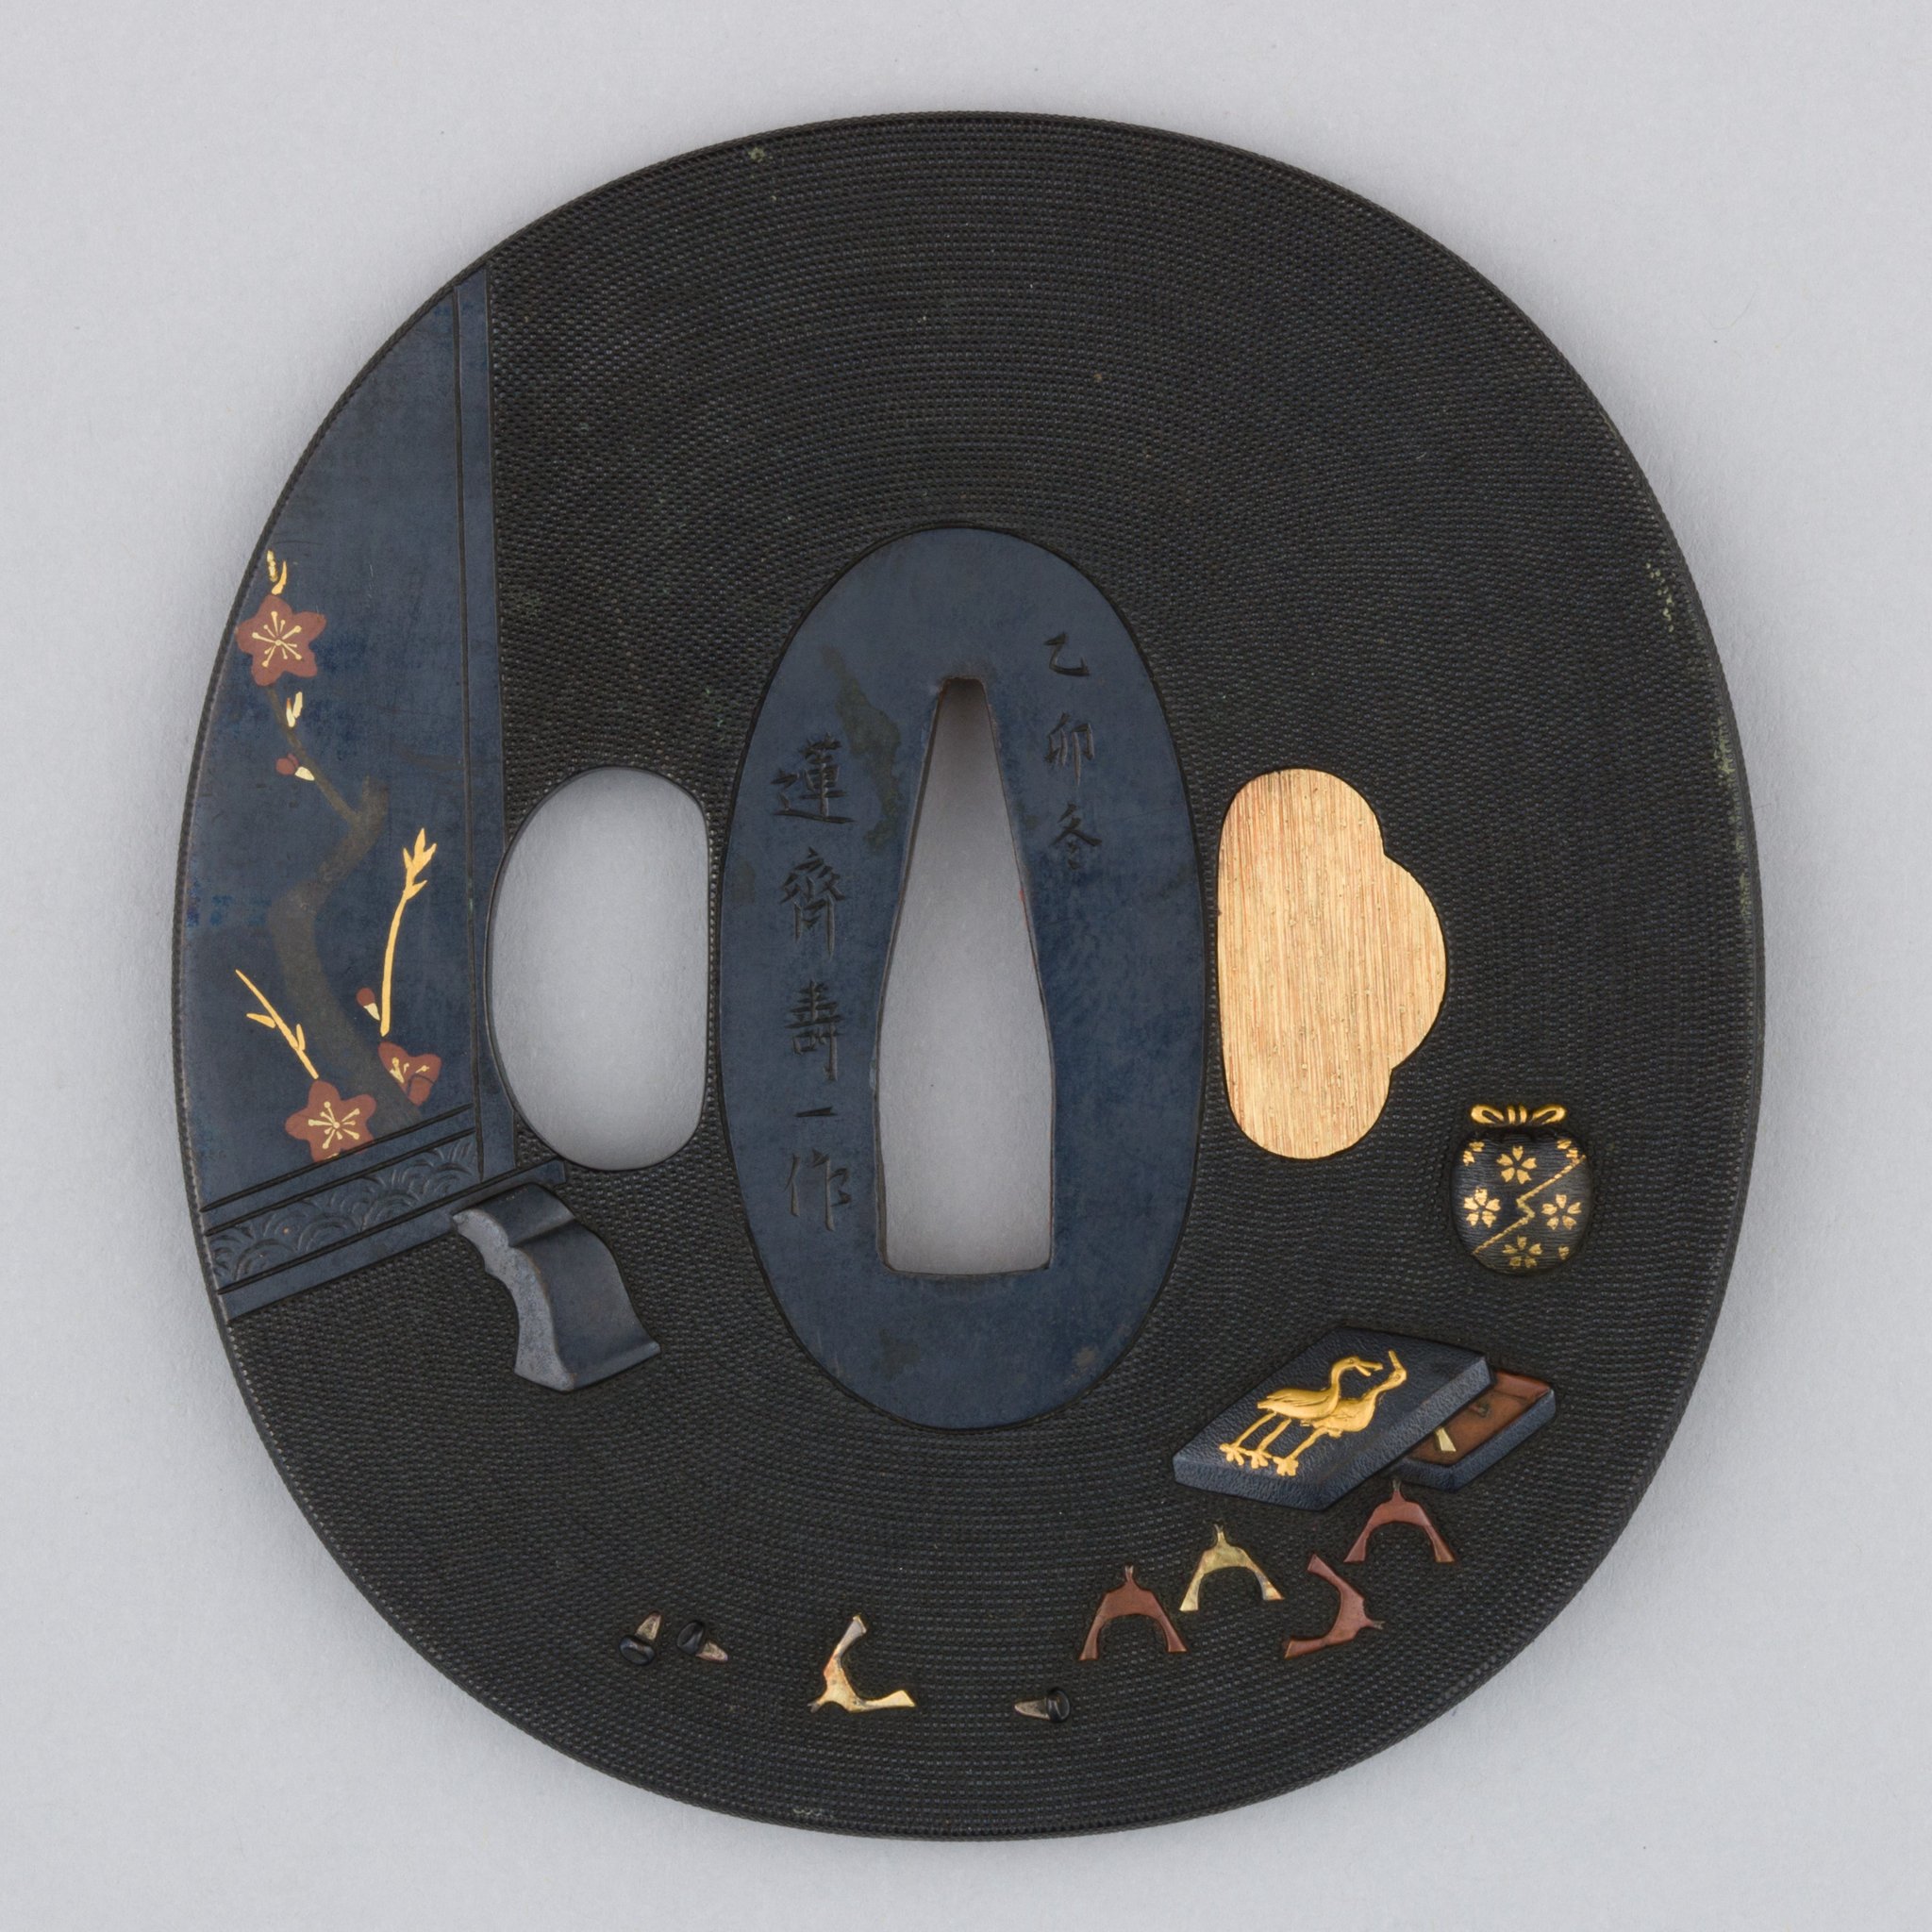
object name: sword guard tsuba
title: Sword Guard (Tsuba)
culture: japanese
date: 1615-1868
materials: copper, gold alloy, silver alloy, gold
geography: japan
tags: birds,flowers